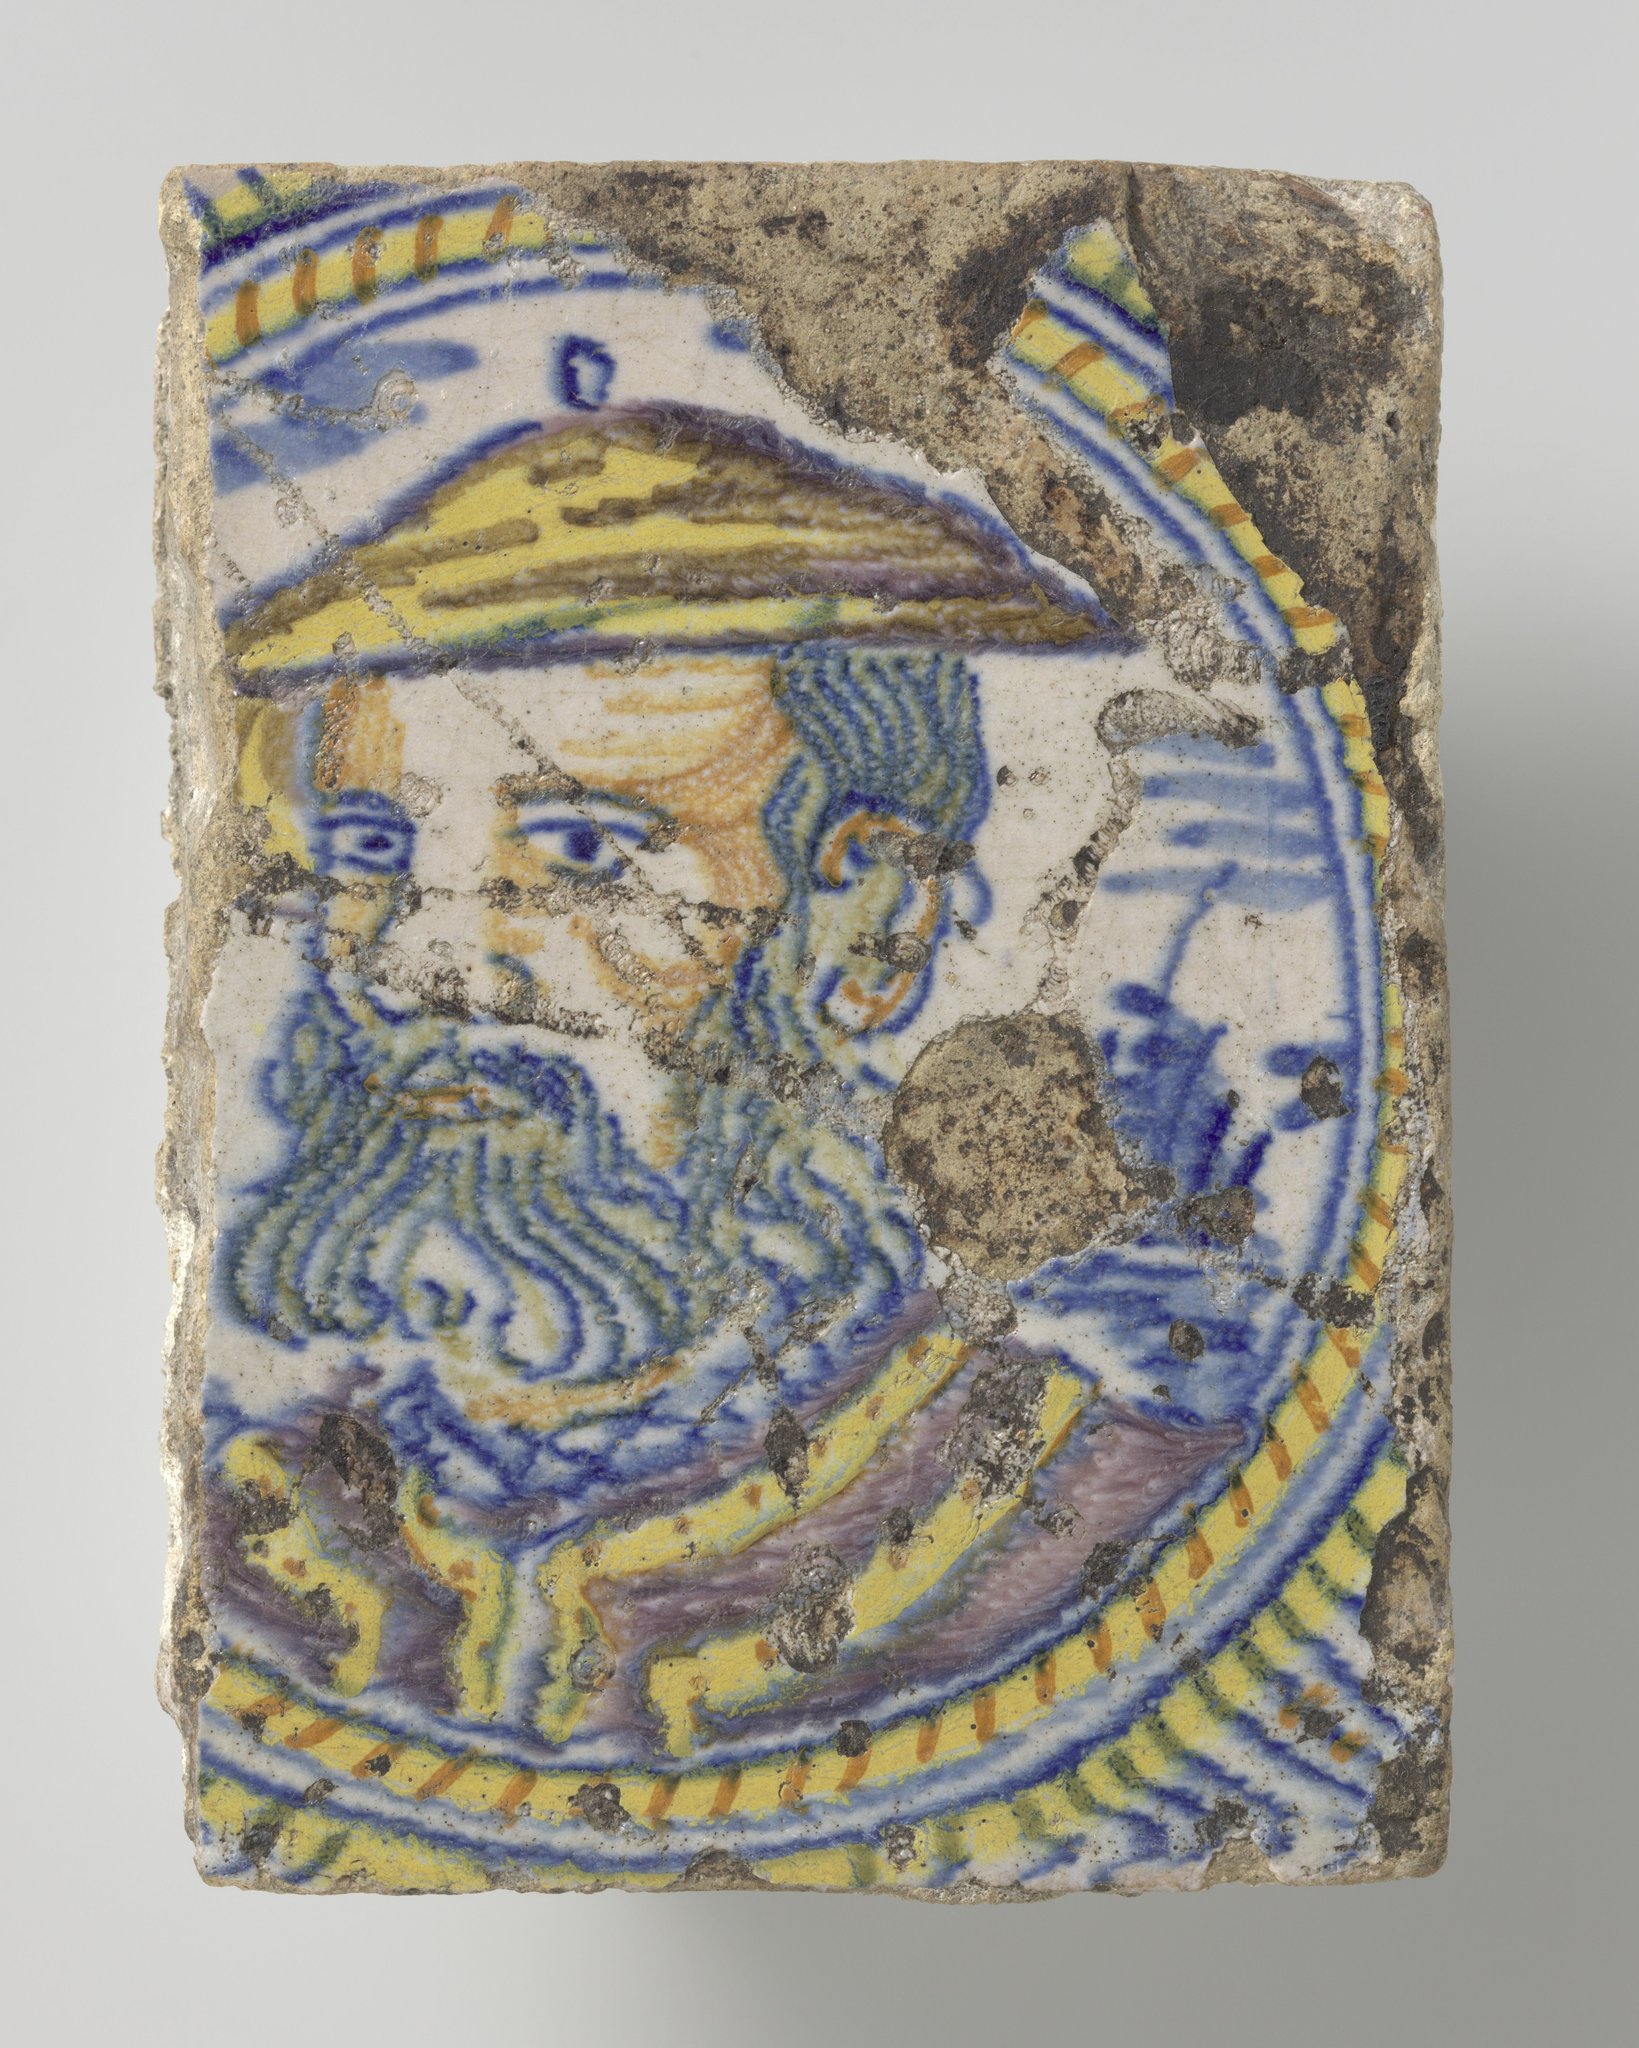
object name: tile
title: Fragment van een tegel met portret van de wederdoper Bernhard Knipperdolling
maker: Anonymous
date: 1530-1570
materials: earthenware, glaze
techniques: maiolica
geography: antwerp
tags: münster, religieus leider, bernardus knipperdolling, wederdopersoproer in münster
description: Fragment van een tegel met een veelkleurig (blauw, paars, geel en oranje) portret van de wederdoper Bernhard Knipperdolling, met baard en baret, omlijst door een cirkel, omgeven door lijnen die doorlopen naar de hoeken.